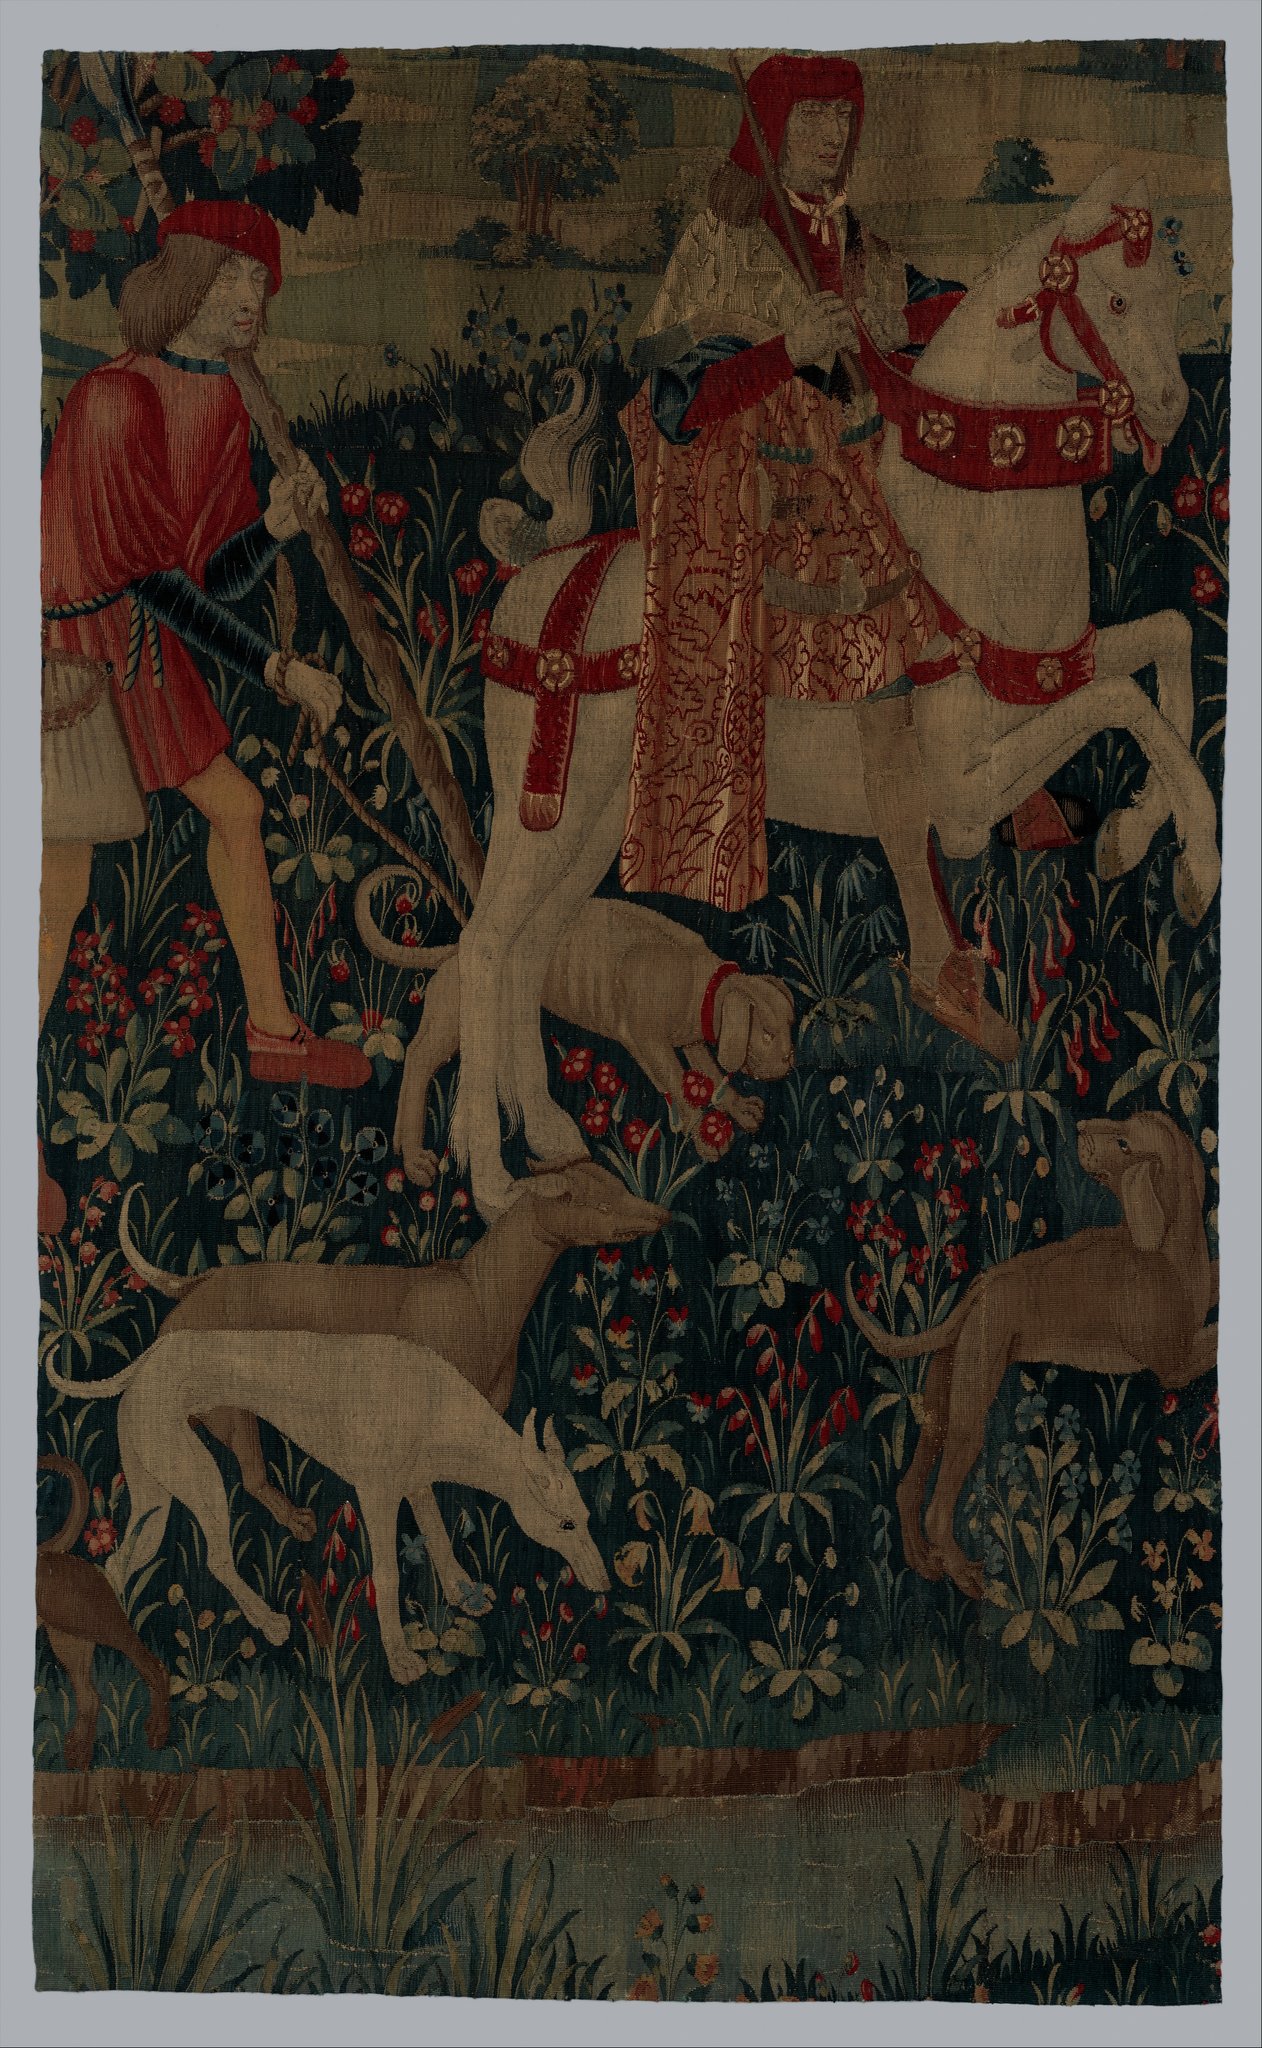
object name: tapestry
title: Following the Stag's Trail (From Incidents in a Stag Hunt)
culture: south netherlandish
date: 1495-1515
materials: wool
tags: men,dogs